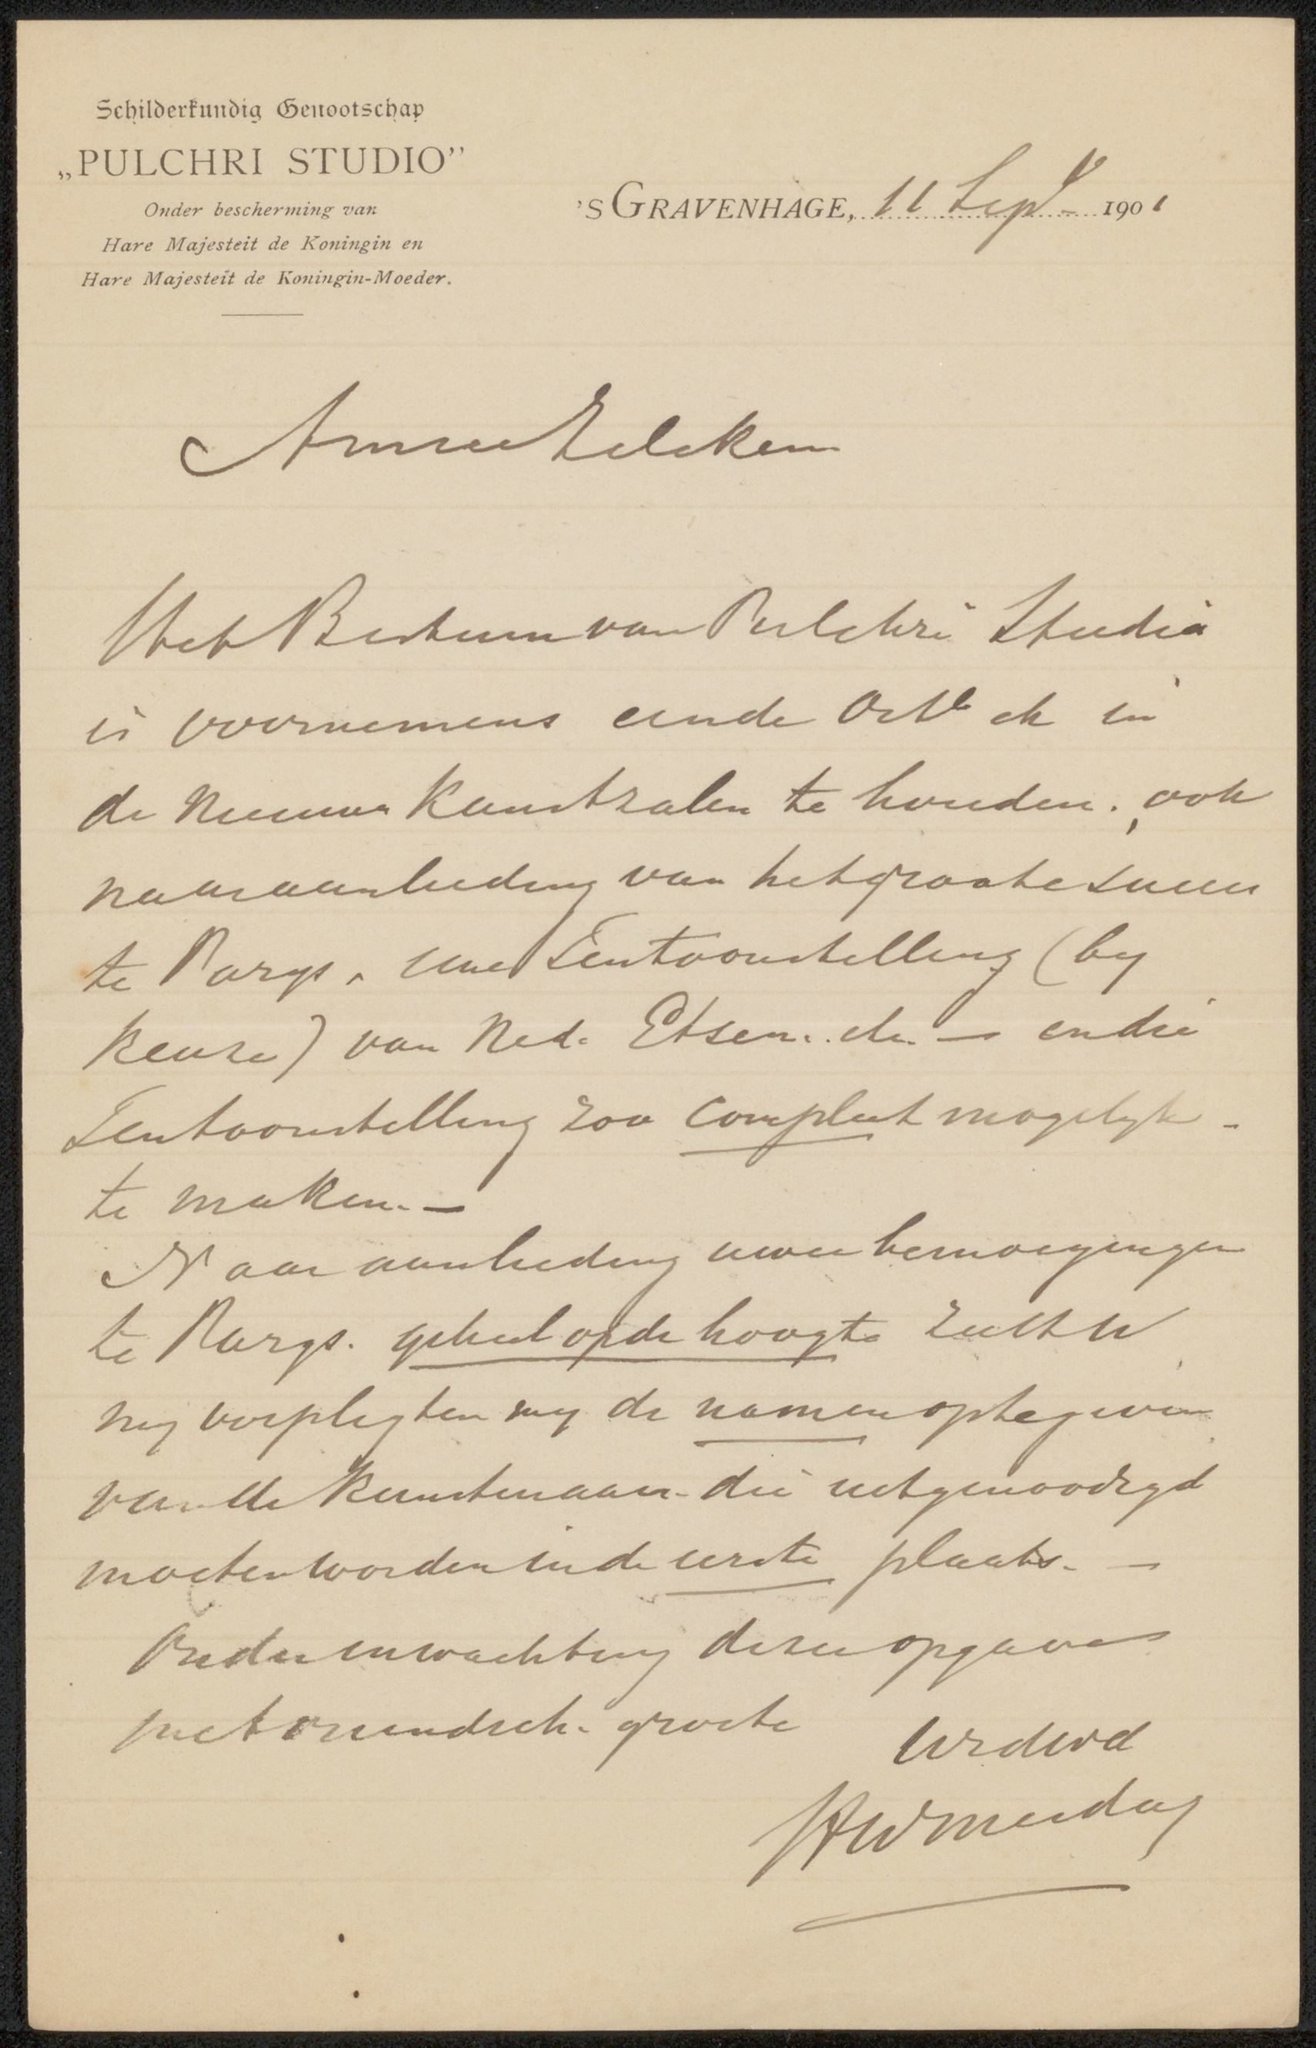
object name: letter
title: Brief aan Philip Zilcken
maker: hendrik willem mesdag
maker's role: draughtsman, painter, print maker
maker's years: 1831-1915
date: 1901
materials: ink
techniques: pen, printing, writing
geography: the hague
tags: the hague, painter, philip zilcken, the graphic arts, exhibition ~ art, paris